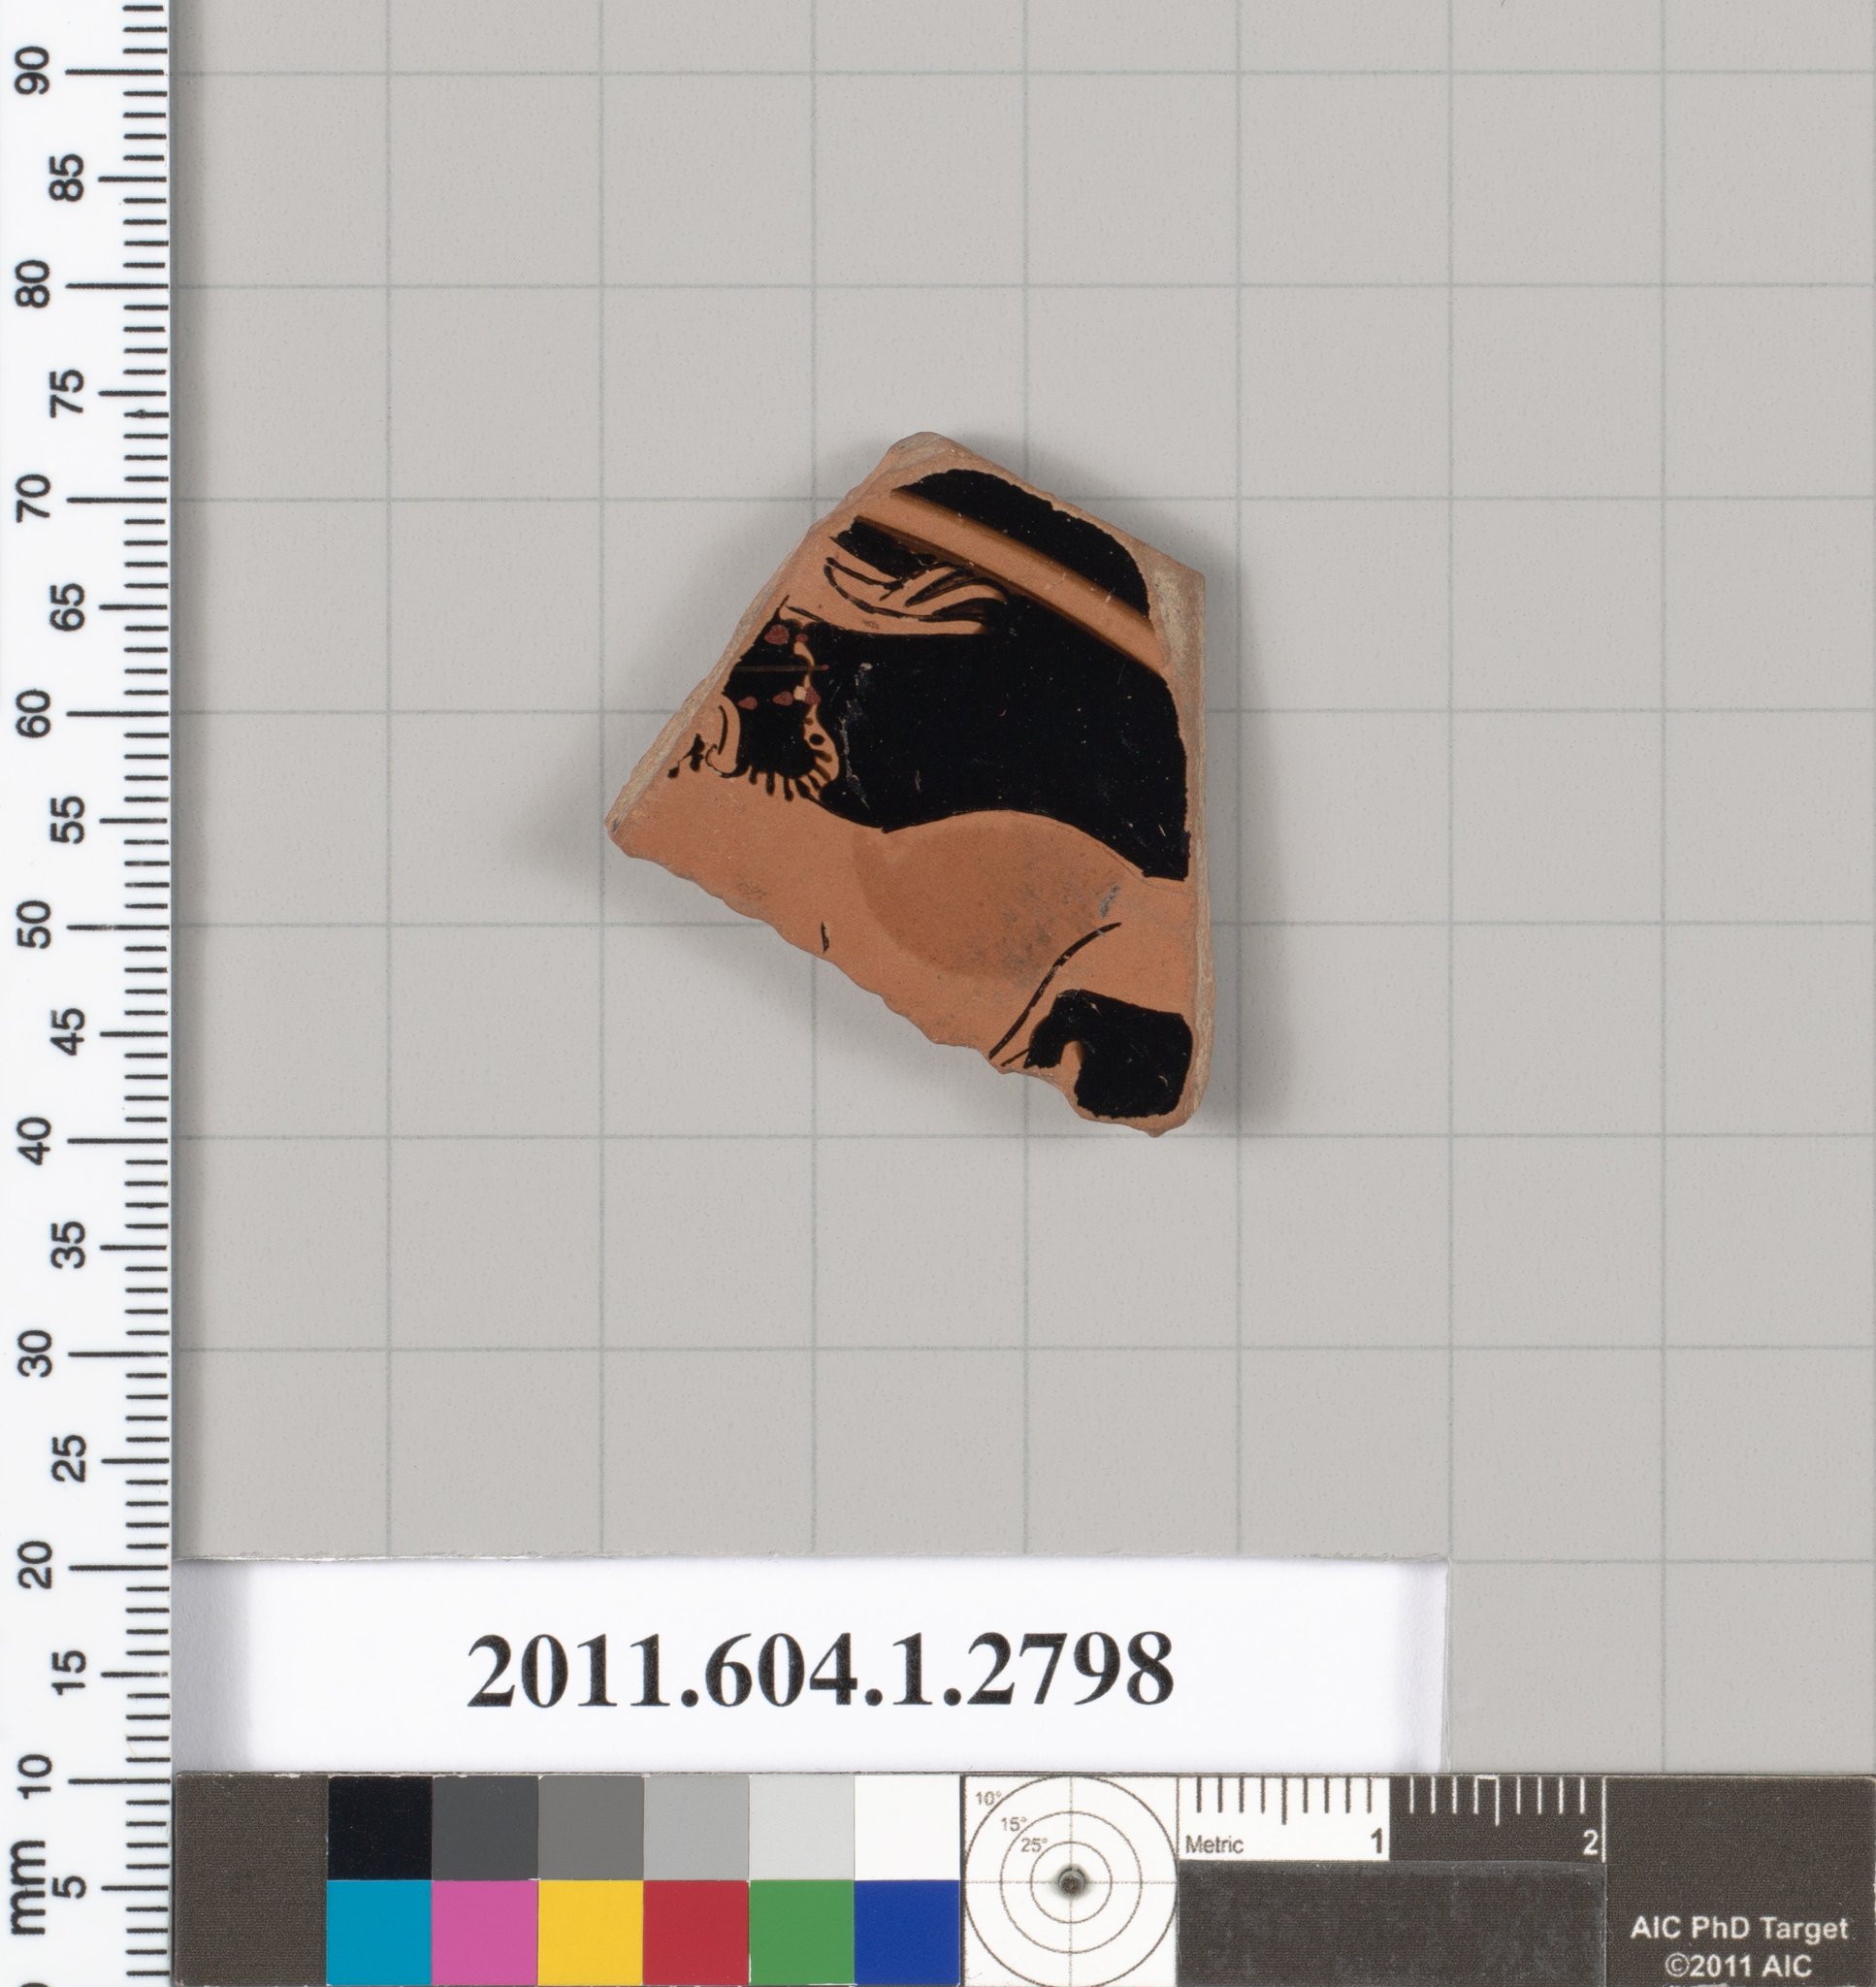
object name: kylix fragment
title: Terracotta fragment of a kylix (drinking cup)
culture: greek, attic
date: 520-500 BCE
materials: terracotta